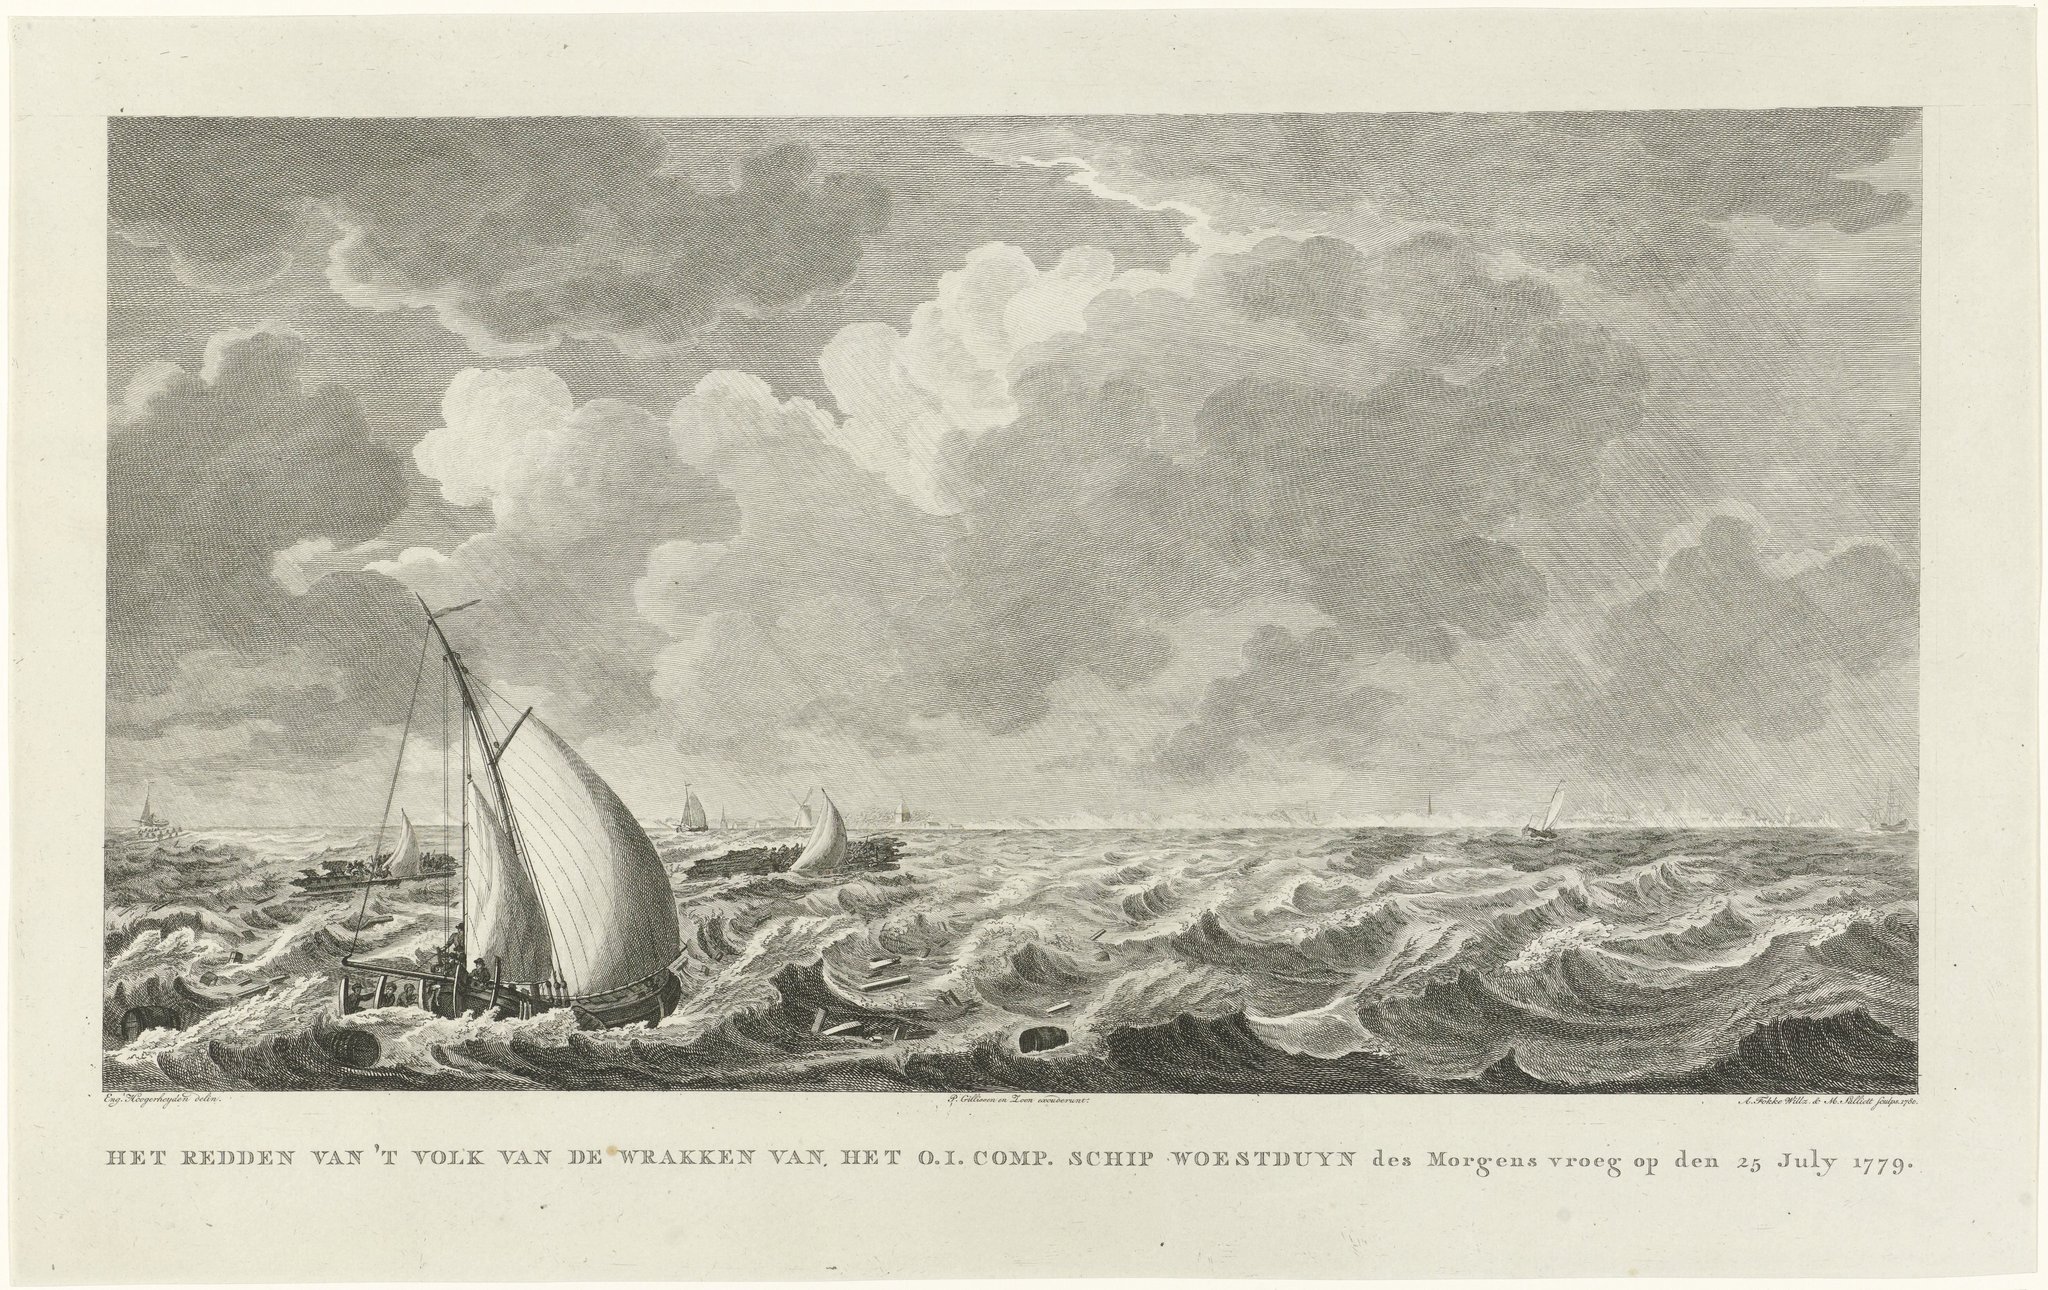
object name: print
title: Redden van de opvarenden van het schip Woestduin, 1779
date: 1780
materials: paper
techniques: engraving, etching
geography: northern netherlands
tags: shipwreck (+ saving the victims ~ traffic accident)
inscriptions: collector's mark: Lugt 2228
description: Het redden van de opvarenden door de gebroeders Naerebout op de ochtend van 25 juli 1779. Vierde plaat in een serie van vier over de redding door de gebroeders Frans en Jacob Naerebout van de 87 opvarenden van het VOC-schip Woestduin (Woestduyn) dat op 24 juli 1779 strandde bij de Noorderrassen (voor de kust van Westkapelle).